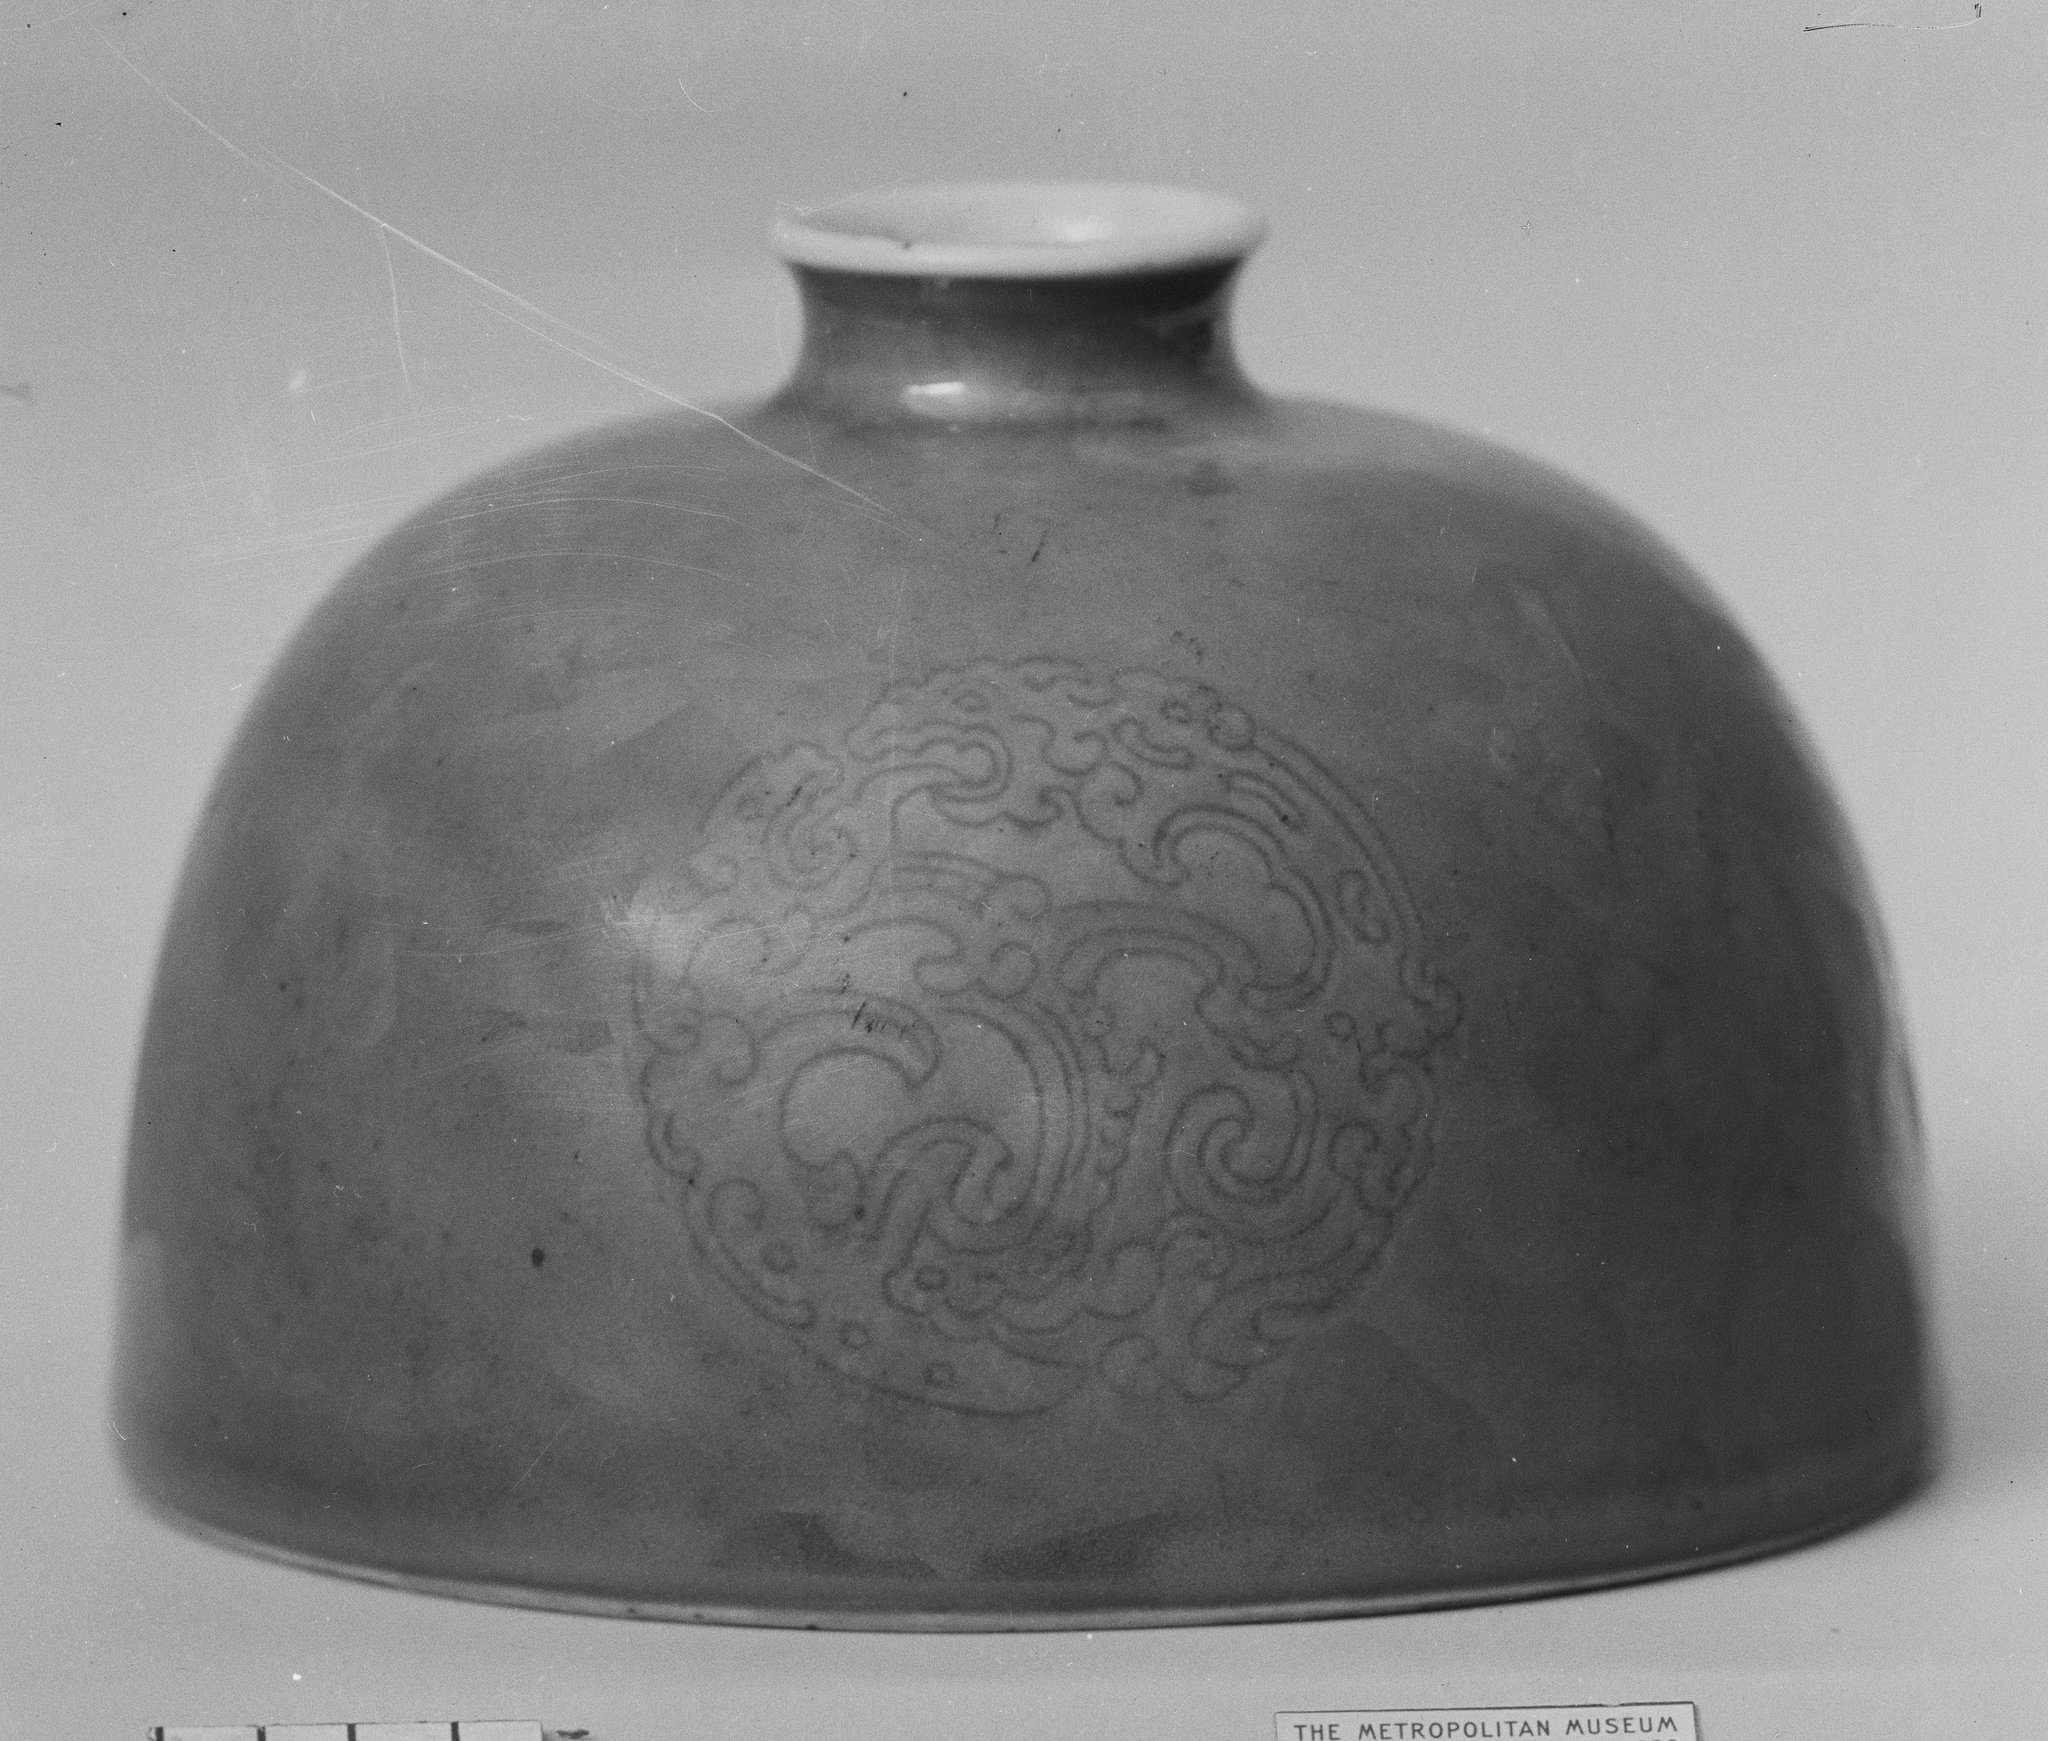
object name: water coupe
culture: chinese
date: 1662-1722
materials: glaze, porcelain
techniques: incising